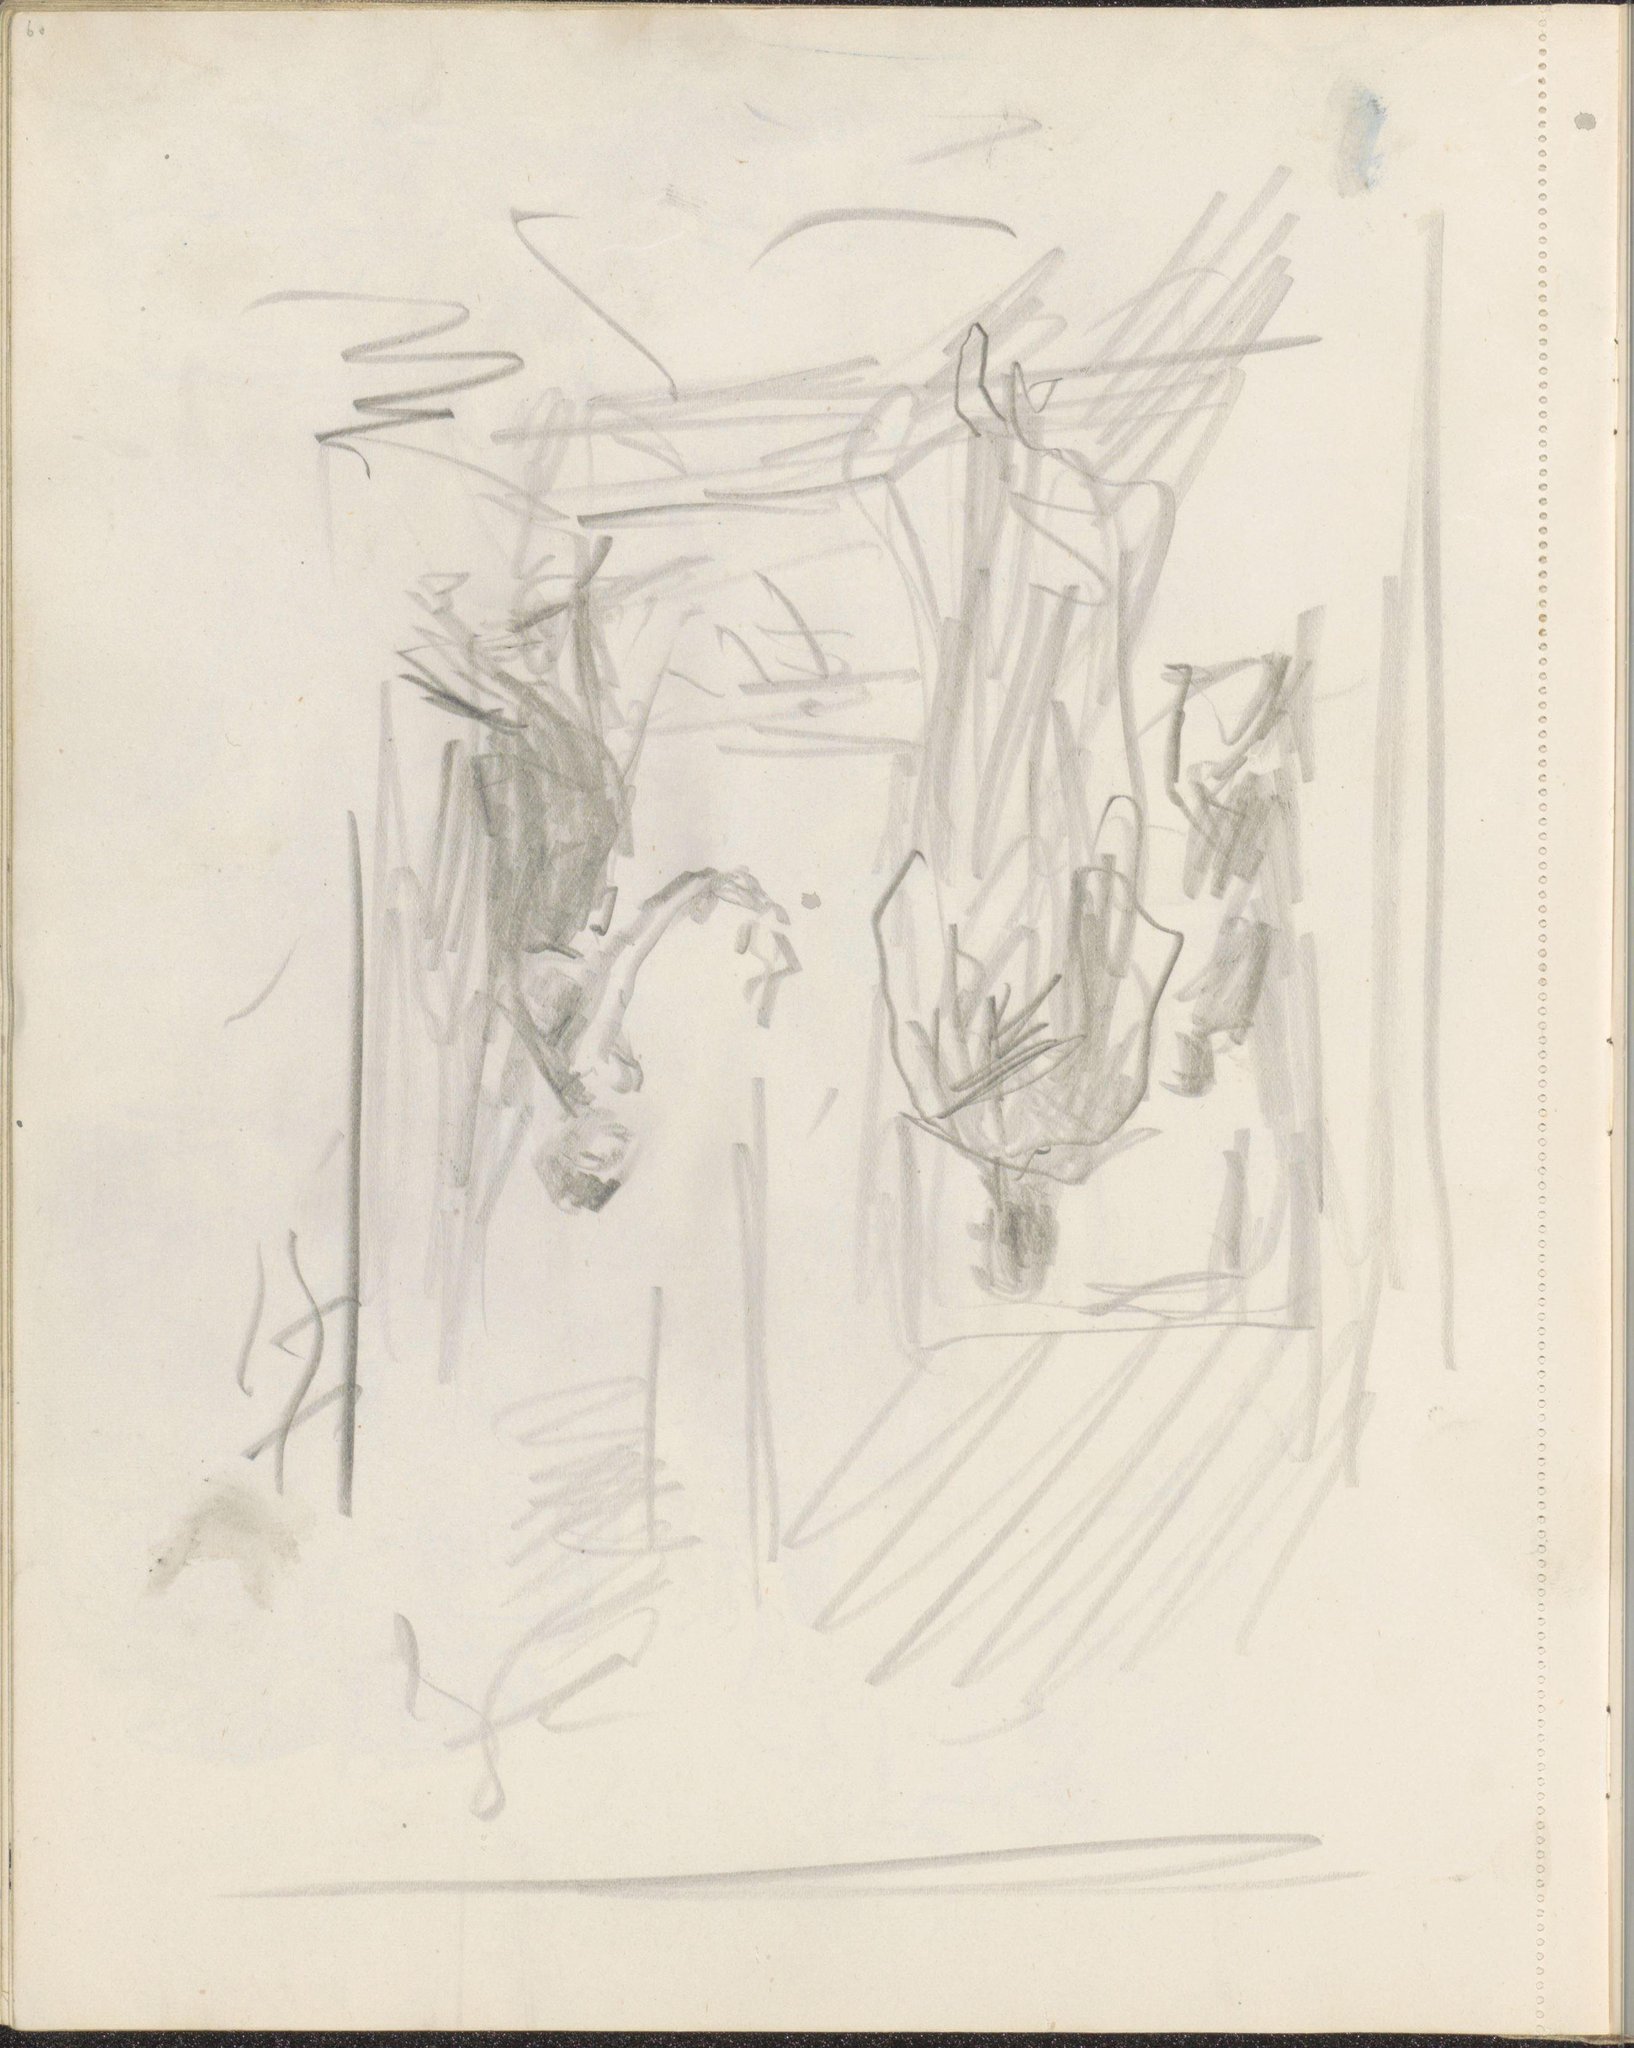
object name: sketchbook leaf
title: Figuren in een interieur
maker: marius bauer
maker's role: draughtsman, print maker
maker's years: 1867-1932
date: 1931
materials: paper, pencil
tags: interior ~ representation of a building, religious functionaries ~ hinduism, buddhism, jainism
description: Mogelijk een monnik in een tempel. Pagina 60 uit een schetsboek met 48 bladen.